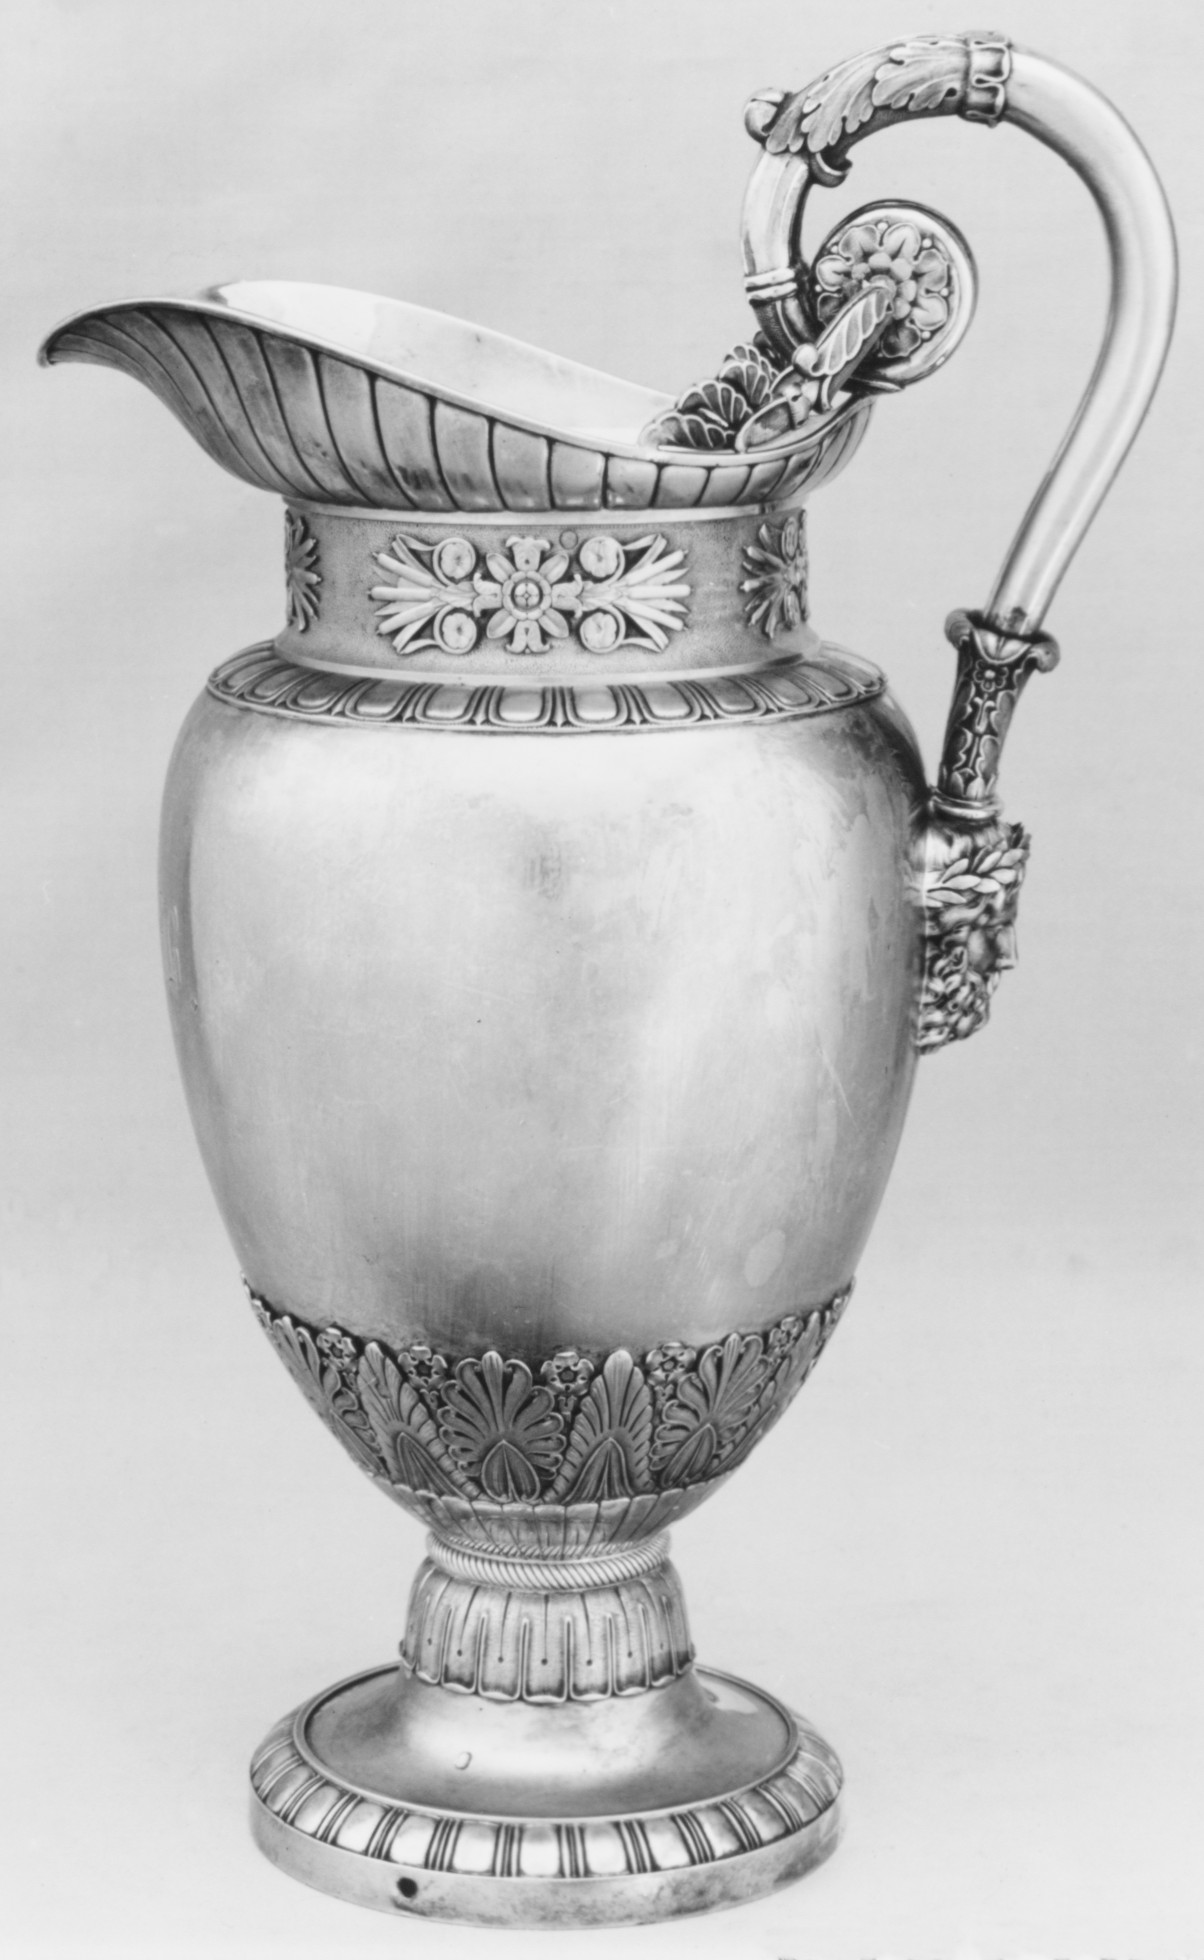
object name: ewer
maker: j.f.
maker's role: maker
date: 1793-1794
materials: silver